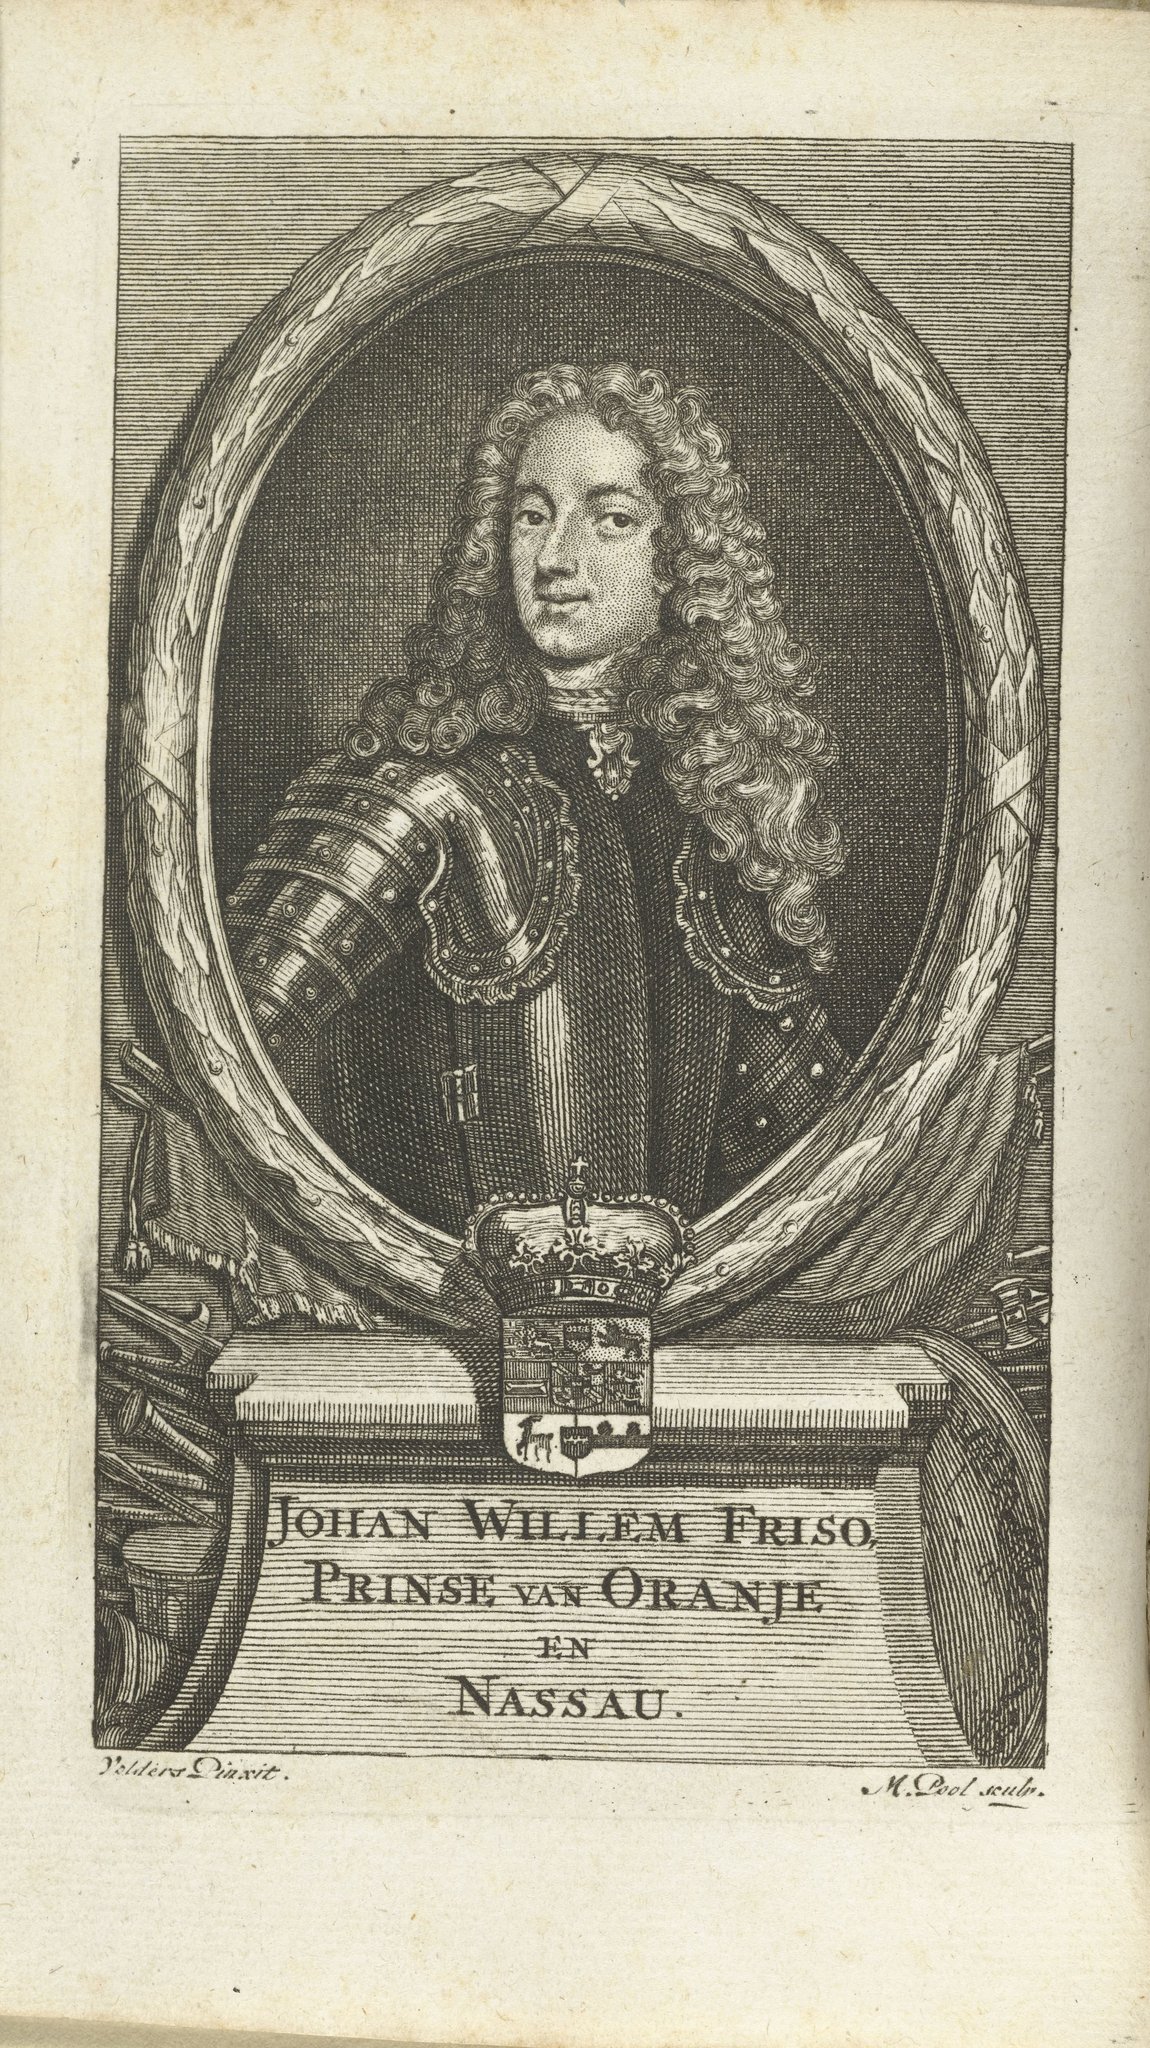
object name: print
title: Johan Willem Friso, Prinse van Oranje en Nassau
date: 1716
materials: paper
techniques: etching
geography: northern netherlands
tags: johan willem friso (prins van oranje-nassau)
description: Frontispice met een portret van Johan Willem Friso, prins van Oranje-Nassau, ten halven lijve in wapenrusting in ovaal. Illustratie in de Nederlandse vertaling uit 1716 van J. Lamigue, Het leven van Zyne Hoogheit Johan Willem Friso.